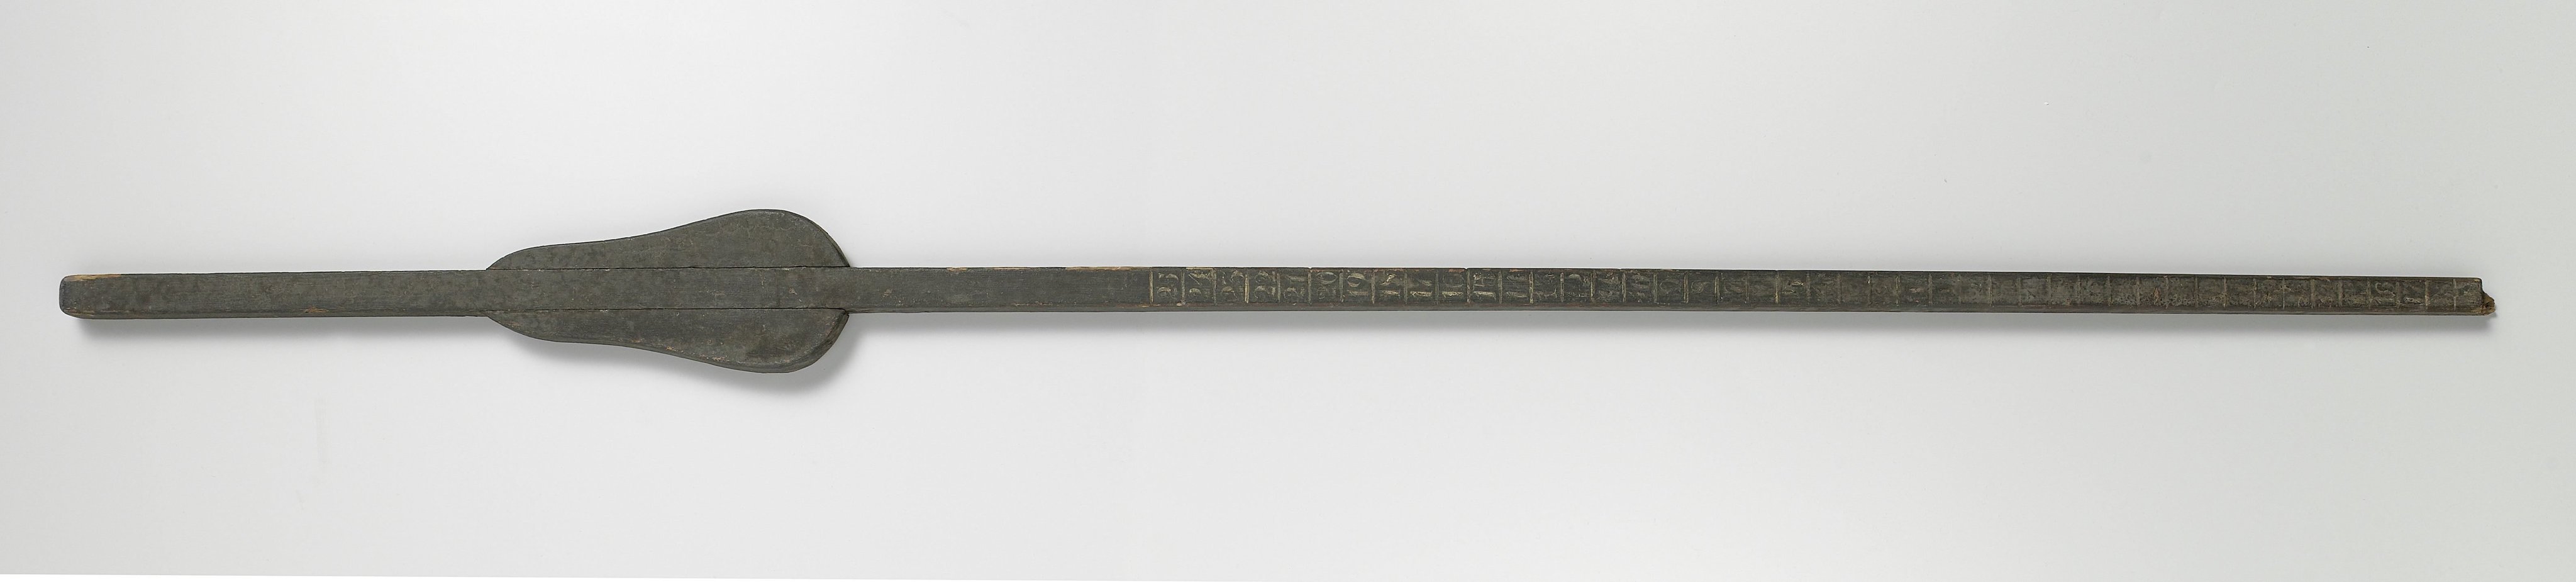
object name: measuring rod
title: Het Amsterdams peil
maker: Anonymous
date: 1400-1950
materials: copper, lead, paint, wood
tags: nieuwmarkt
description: Stok met de aanduiding van het Amsterdams peil. De stok is gebruikt bij het Stadswaterkantoor aan de Nieuwmarkt. Bij de stok behoren tevens een oud stuk lood en een koperen ring, die zich echter niet in het depot bevinden.